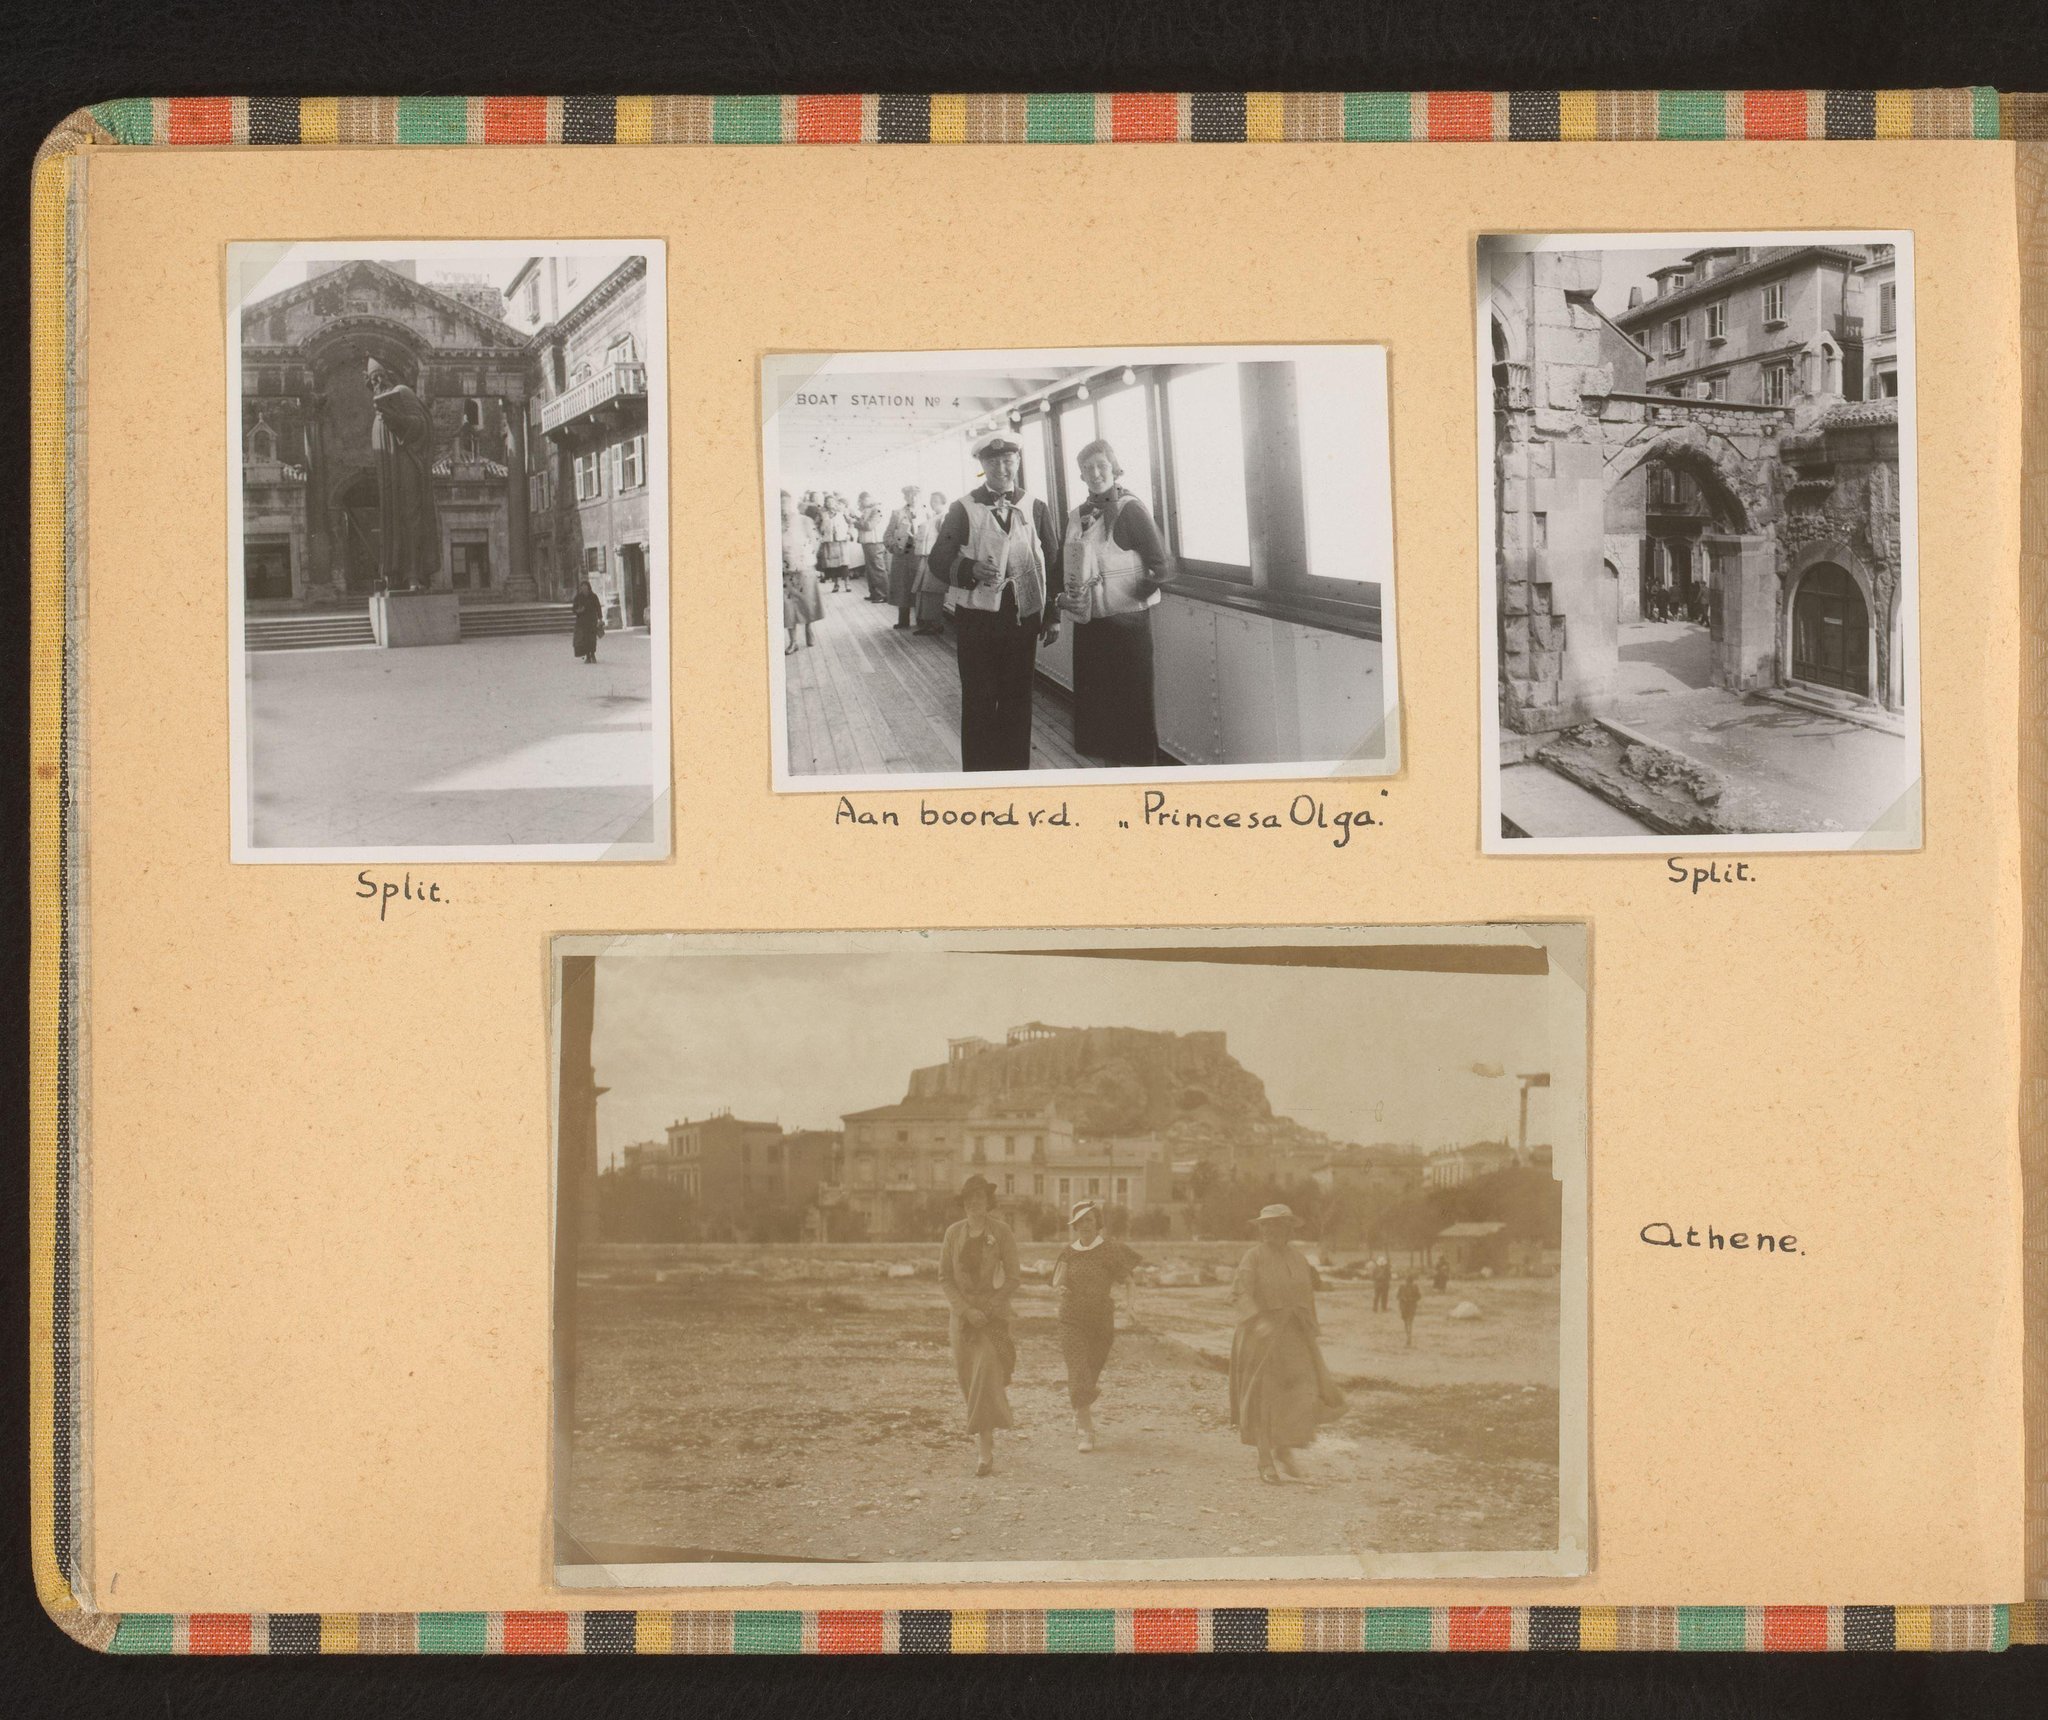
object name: photograph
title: Split en Athene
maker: Anonymous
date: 1936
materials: paper, photographic support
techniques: gelatin silver print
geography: split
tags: tourism, passengers ~ ship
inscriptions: inscription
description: Albumblad met vier foto's, één genomen aan boord van het schip, drie van uitstapjes onderweg te Split en Athene. Alle foto's met onderschriften. Onderdeel van een album over een vakantiereis over de Nijl in 1936.